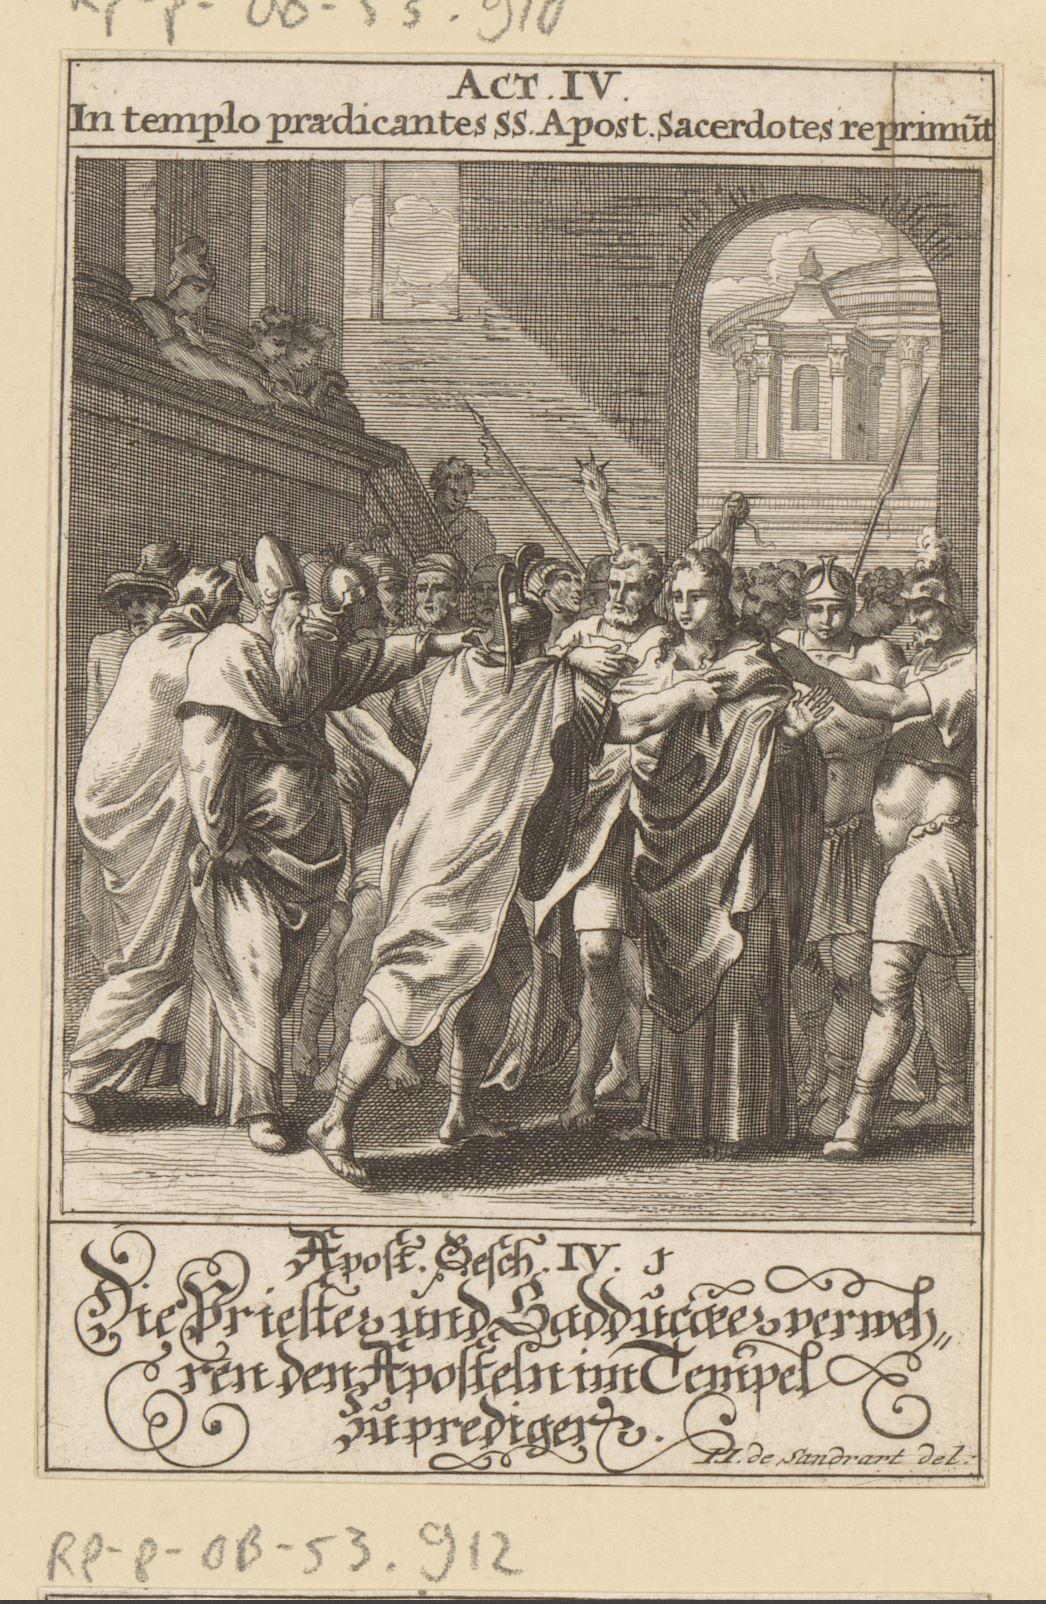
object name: print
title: Priesters en Sadduceeën verbieden de apostelen in de tempel te prediken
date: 1697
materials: paper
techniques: etching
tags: the high priest and sadducees have peter and the apostles put in prison (acts 5:17-42)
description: Prent ook gebruikt in: Biblia ectypa : Bildnussen auss Heiliger Schrifft. Regensburg: Chr. Wiegel, 1697.